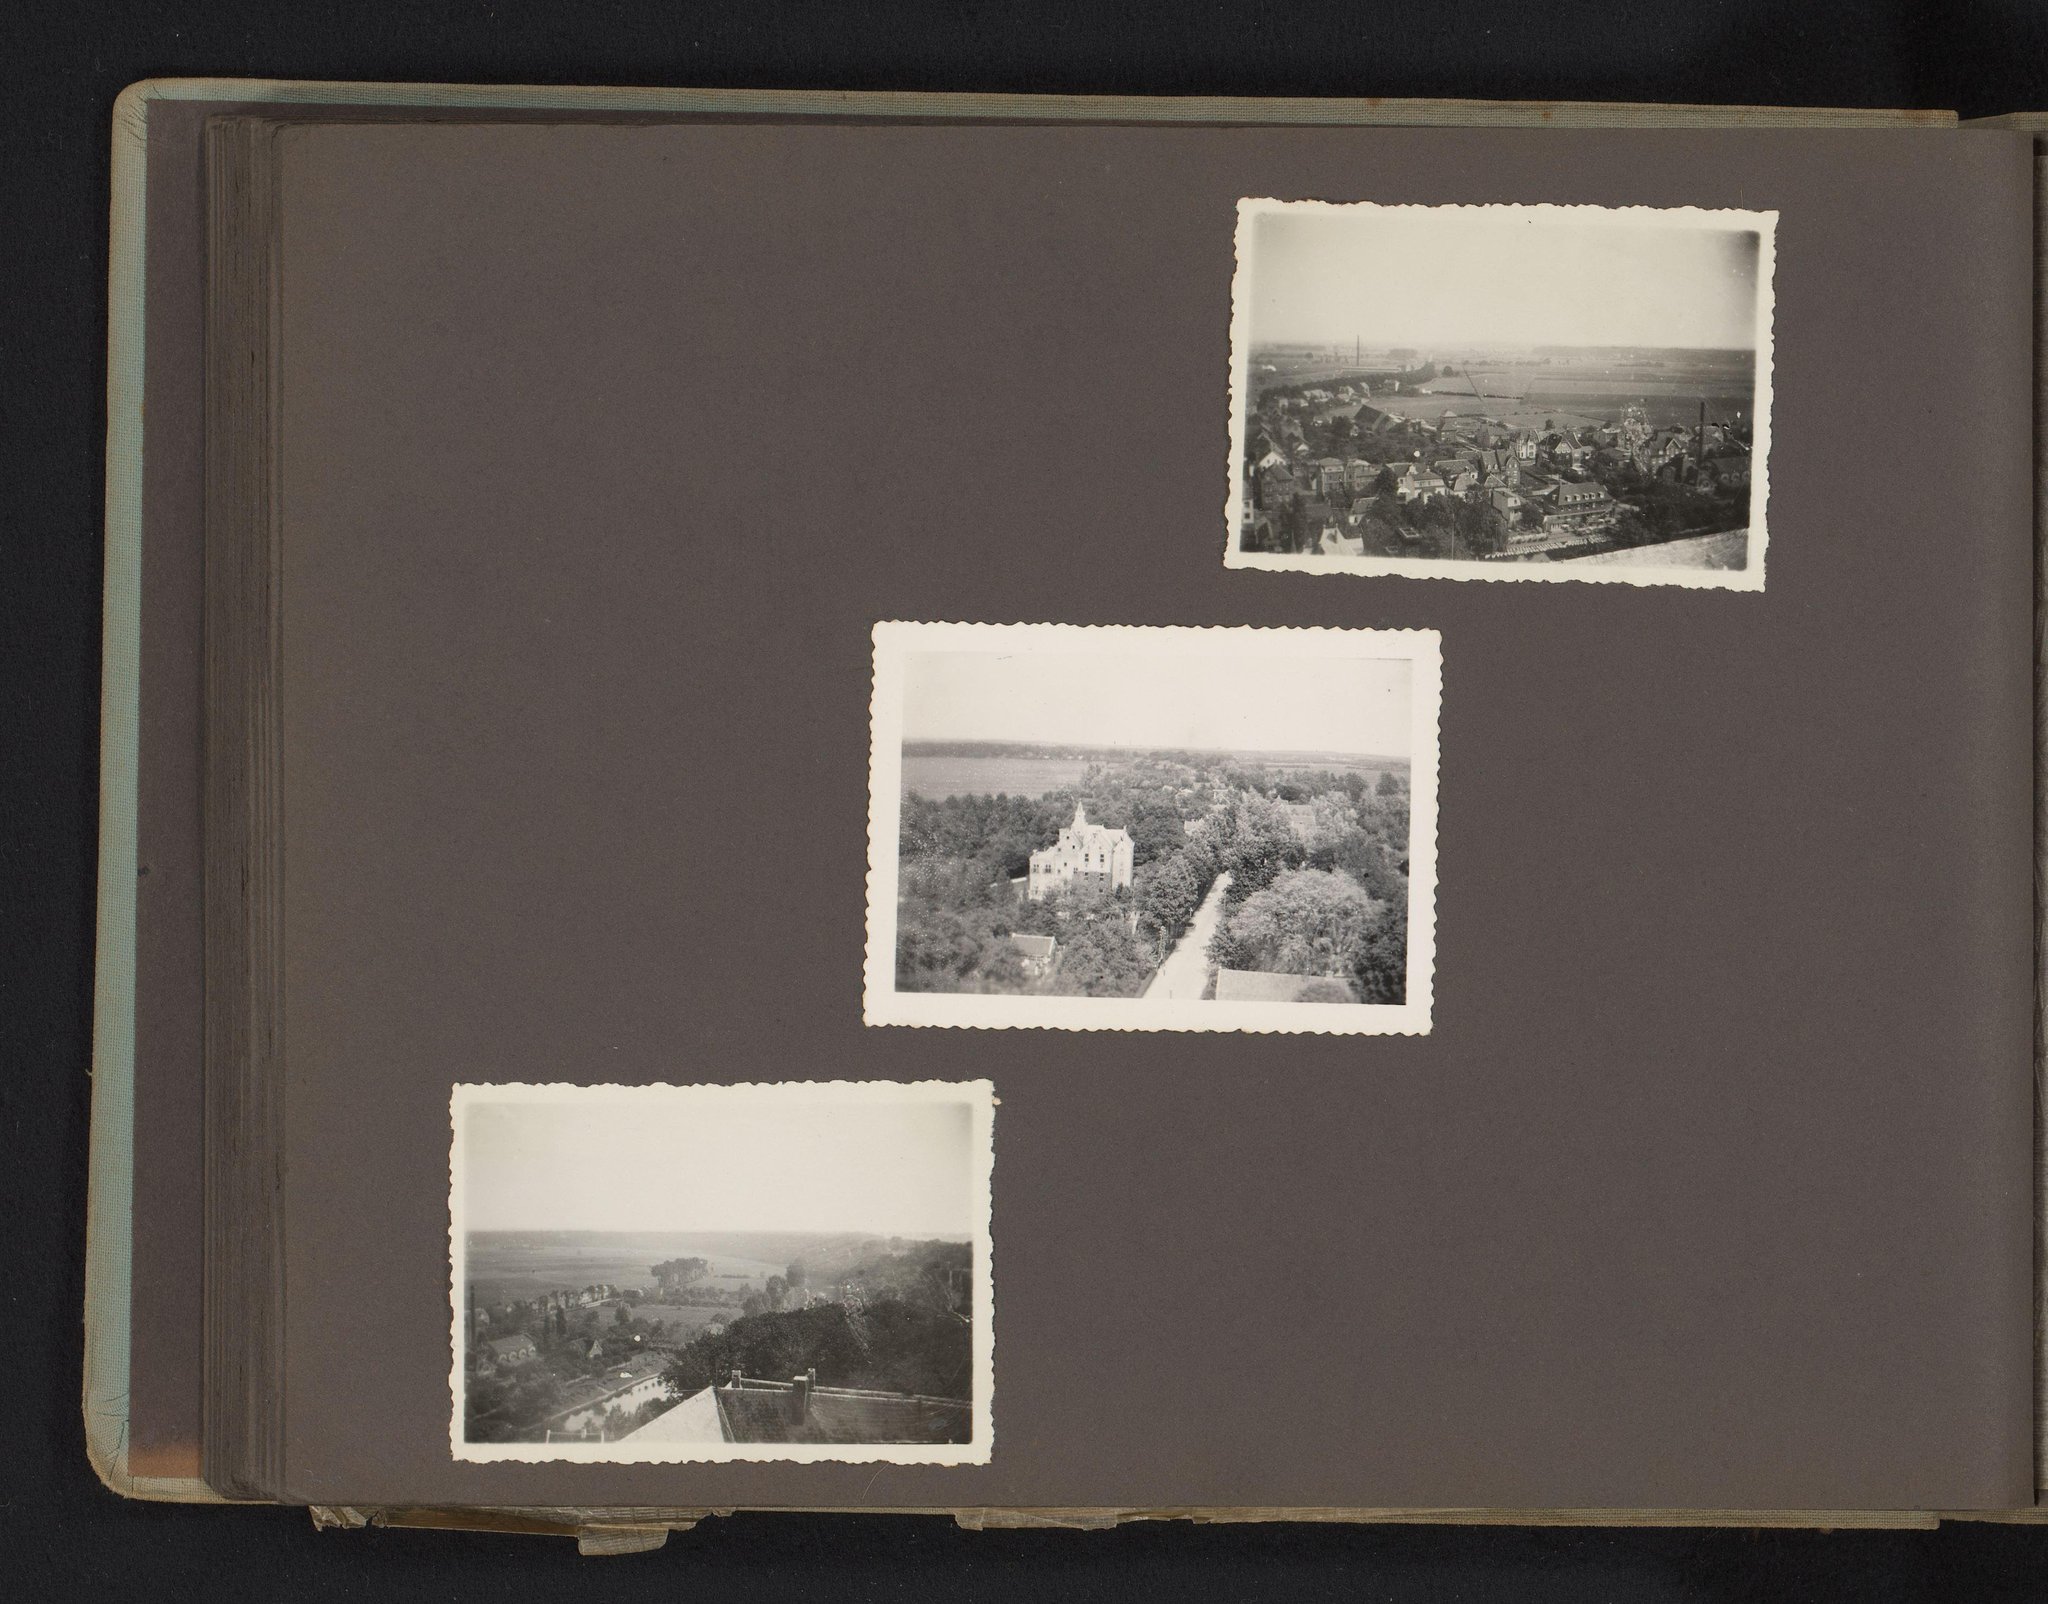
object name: album leaf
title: Uitzicht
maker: Anonymous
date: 1935-1945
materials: cardboard, photographic support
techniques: gelatin silver print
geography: netherlands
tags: outing, pleasure trip, open-air recreation, netherlands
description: Albumblad met drie foto's van een landschap, genomen van een toren. Onderdeel van het fotoalbum van een jonge vrouw, ca. 1935-1945.